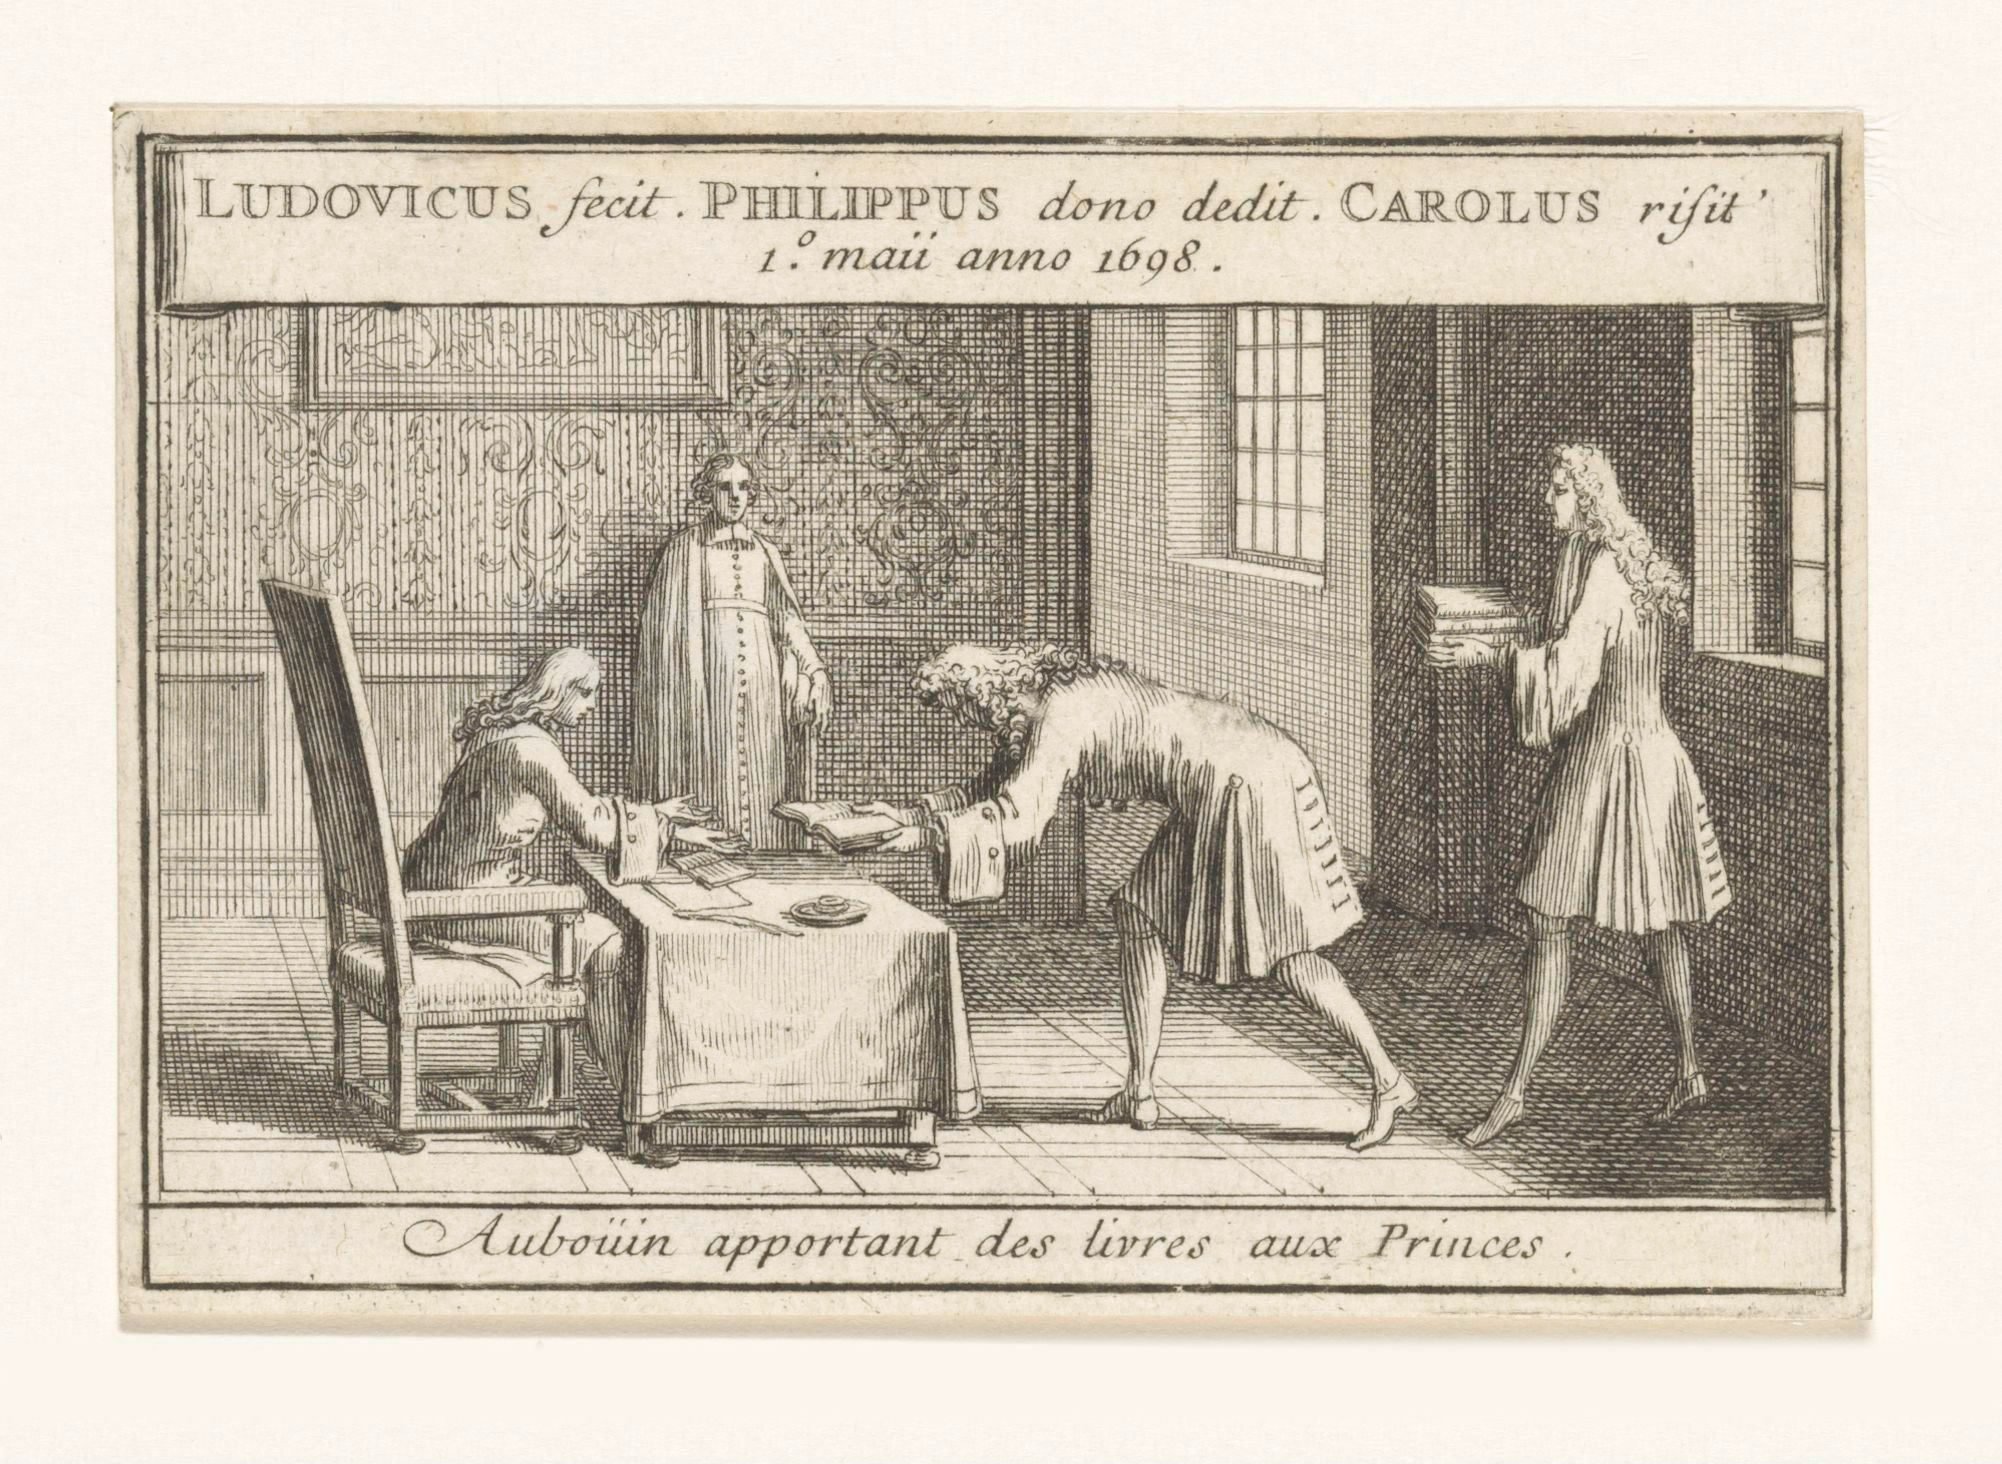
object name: print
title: Aubouin apportant des livres aux Princes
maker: sébastien leclerc (i)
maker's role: print maker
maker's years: 1637-1714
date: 1698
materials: paper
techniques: engraving, etching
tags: lodewijk van frankrijk (hertog van bourgondië), filips v (koning van spanje), court ceremonial, court etiquette, book-shop, bookseller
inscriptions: collector's mark: Lugt 2228, collector's mark: Lugt 4779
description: Bij het aanbieden van een boek aan Lodewijk van Bourgondië, maakt boekhandelaar Abouin een dusdanig diepe buiging dat de hertog er niet in slaagt het boek aan te pakken. Dit tot hilariteit van diens jongere broers, Philips van Anjou en Karel van Berry.